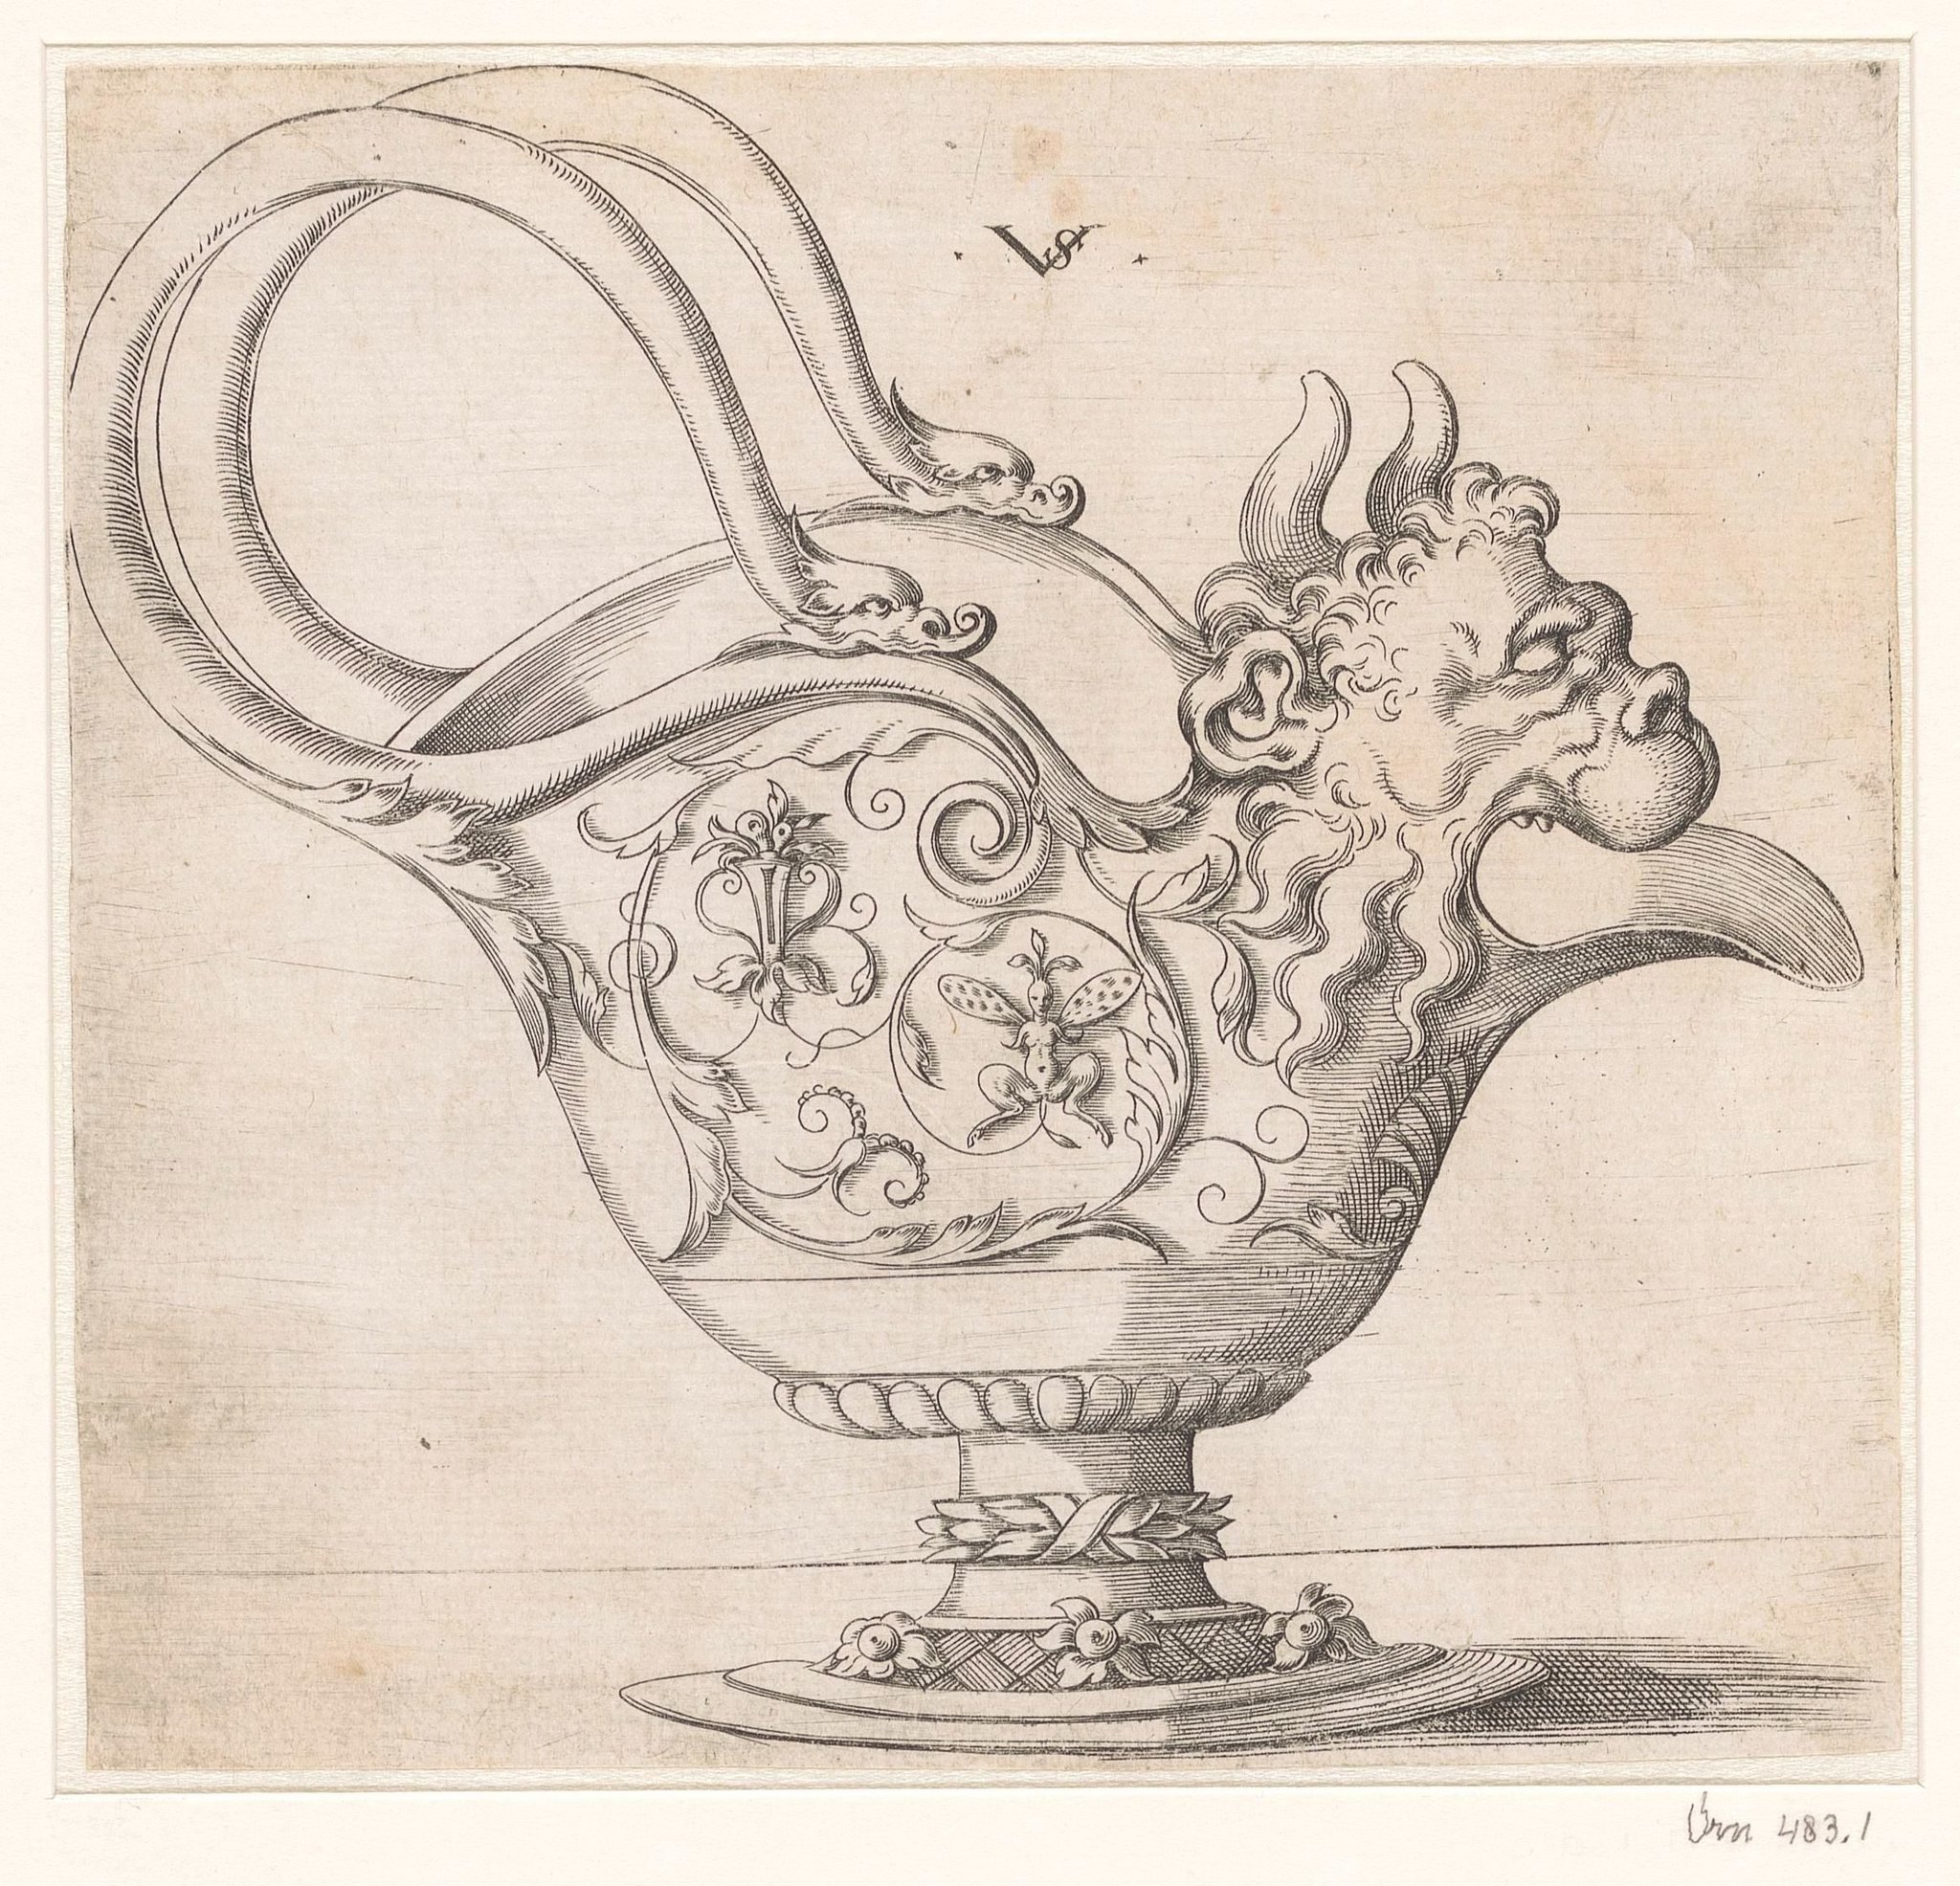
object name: print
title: Ontwerpen voor vaatwerk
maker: virgilius solis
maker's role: draughtsman, print maker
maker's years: 1514-1562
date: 1524-1562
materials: paper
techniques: engraving, etching, intaglio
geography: nuremberg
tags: lion's head ~ ornament, dolphin ~ ornament, animal-shaped drinking-vessel, container of ceramics: jar, jug, pot, vase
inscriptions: collector's mark: Lugt 2228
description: Prent maakt deel uit van een serie van 24 prenten met ontwerpen voor vaatwerk.